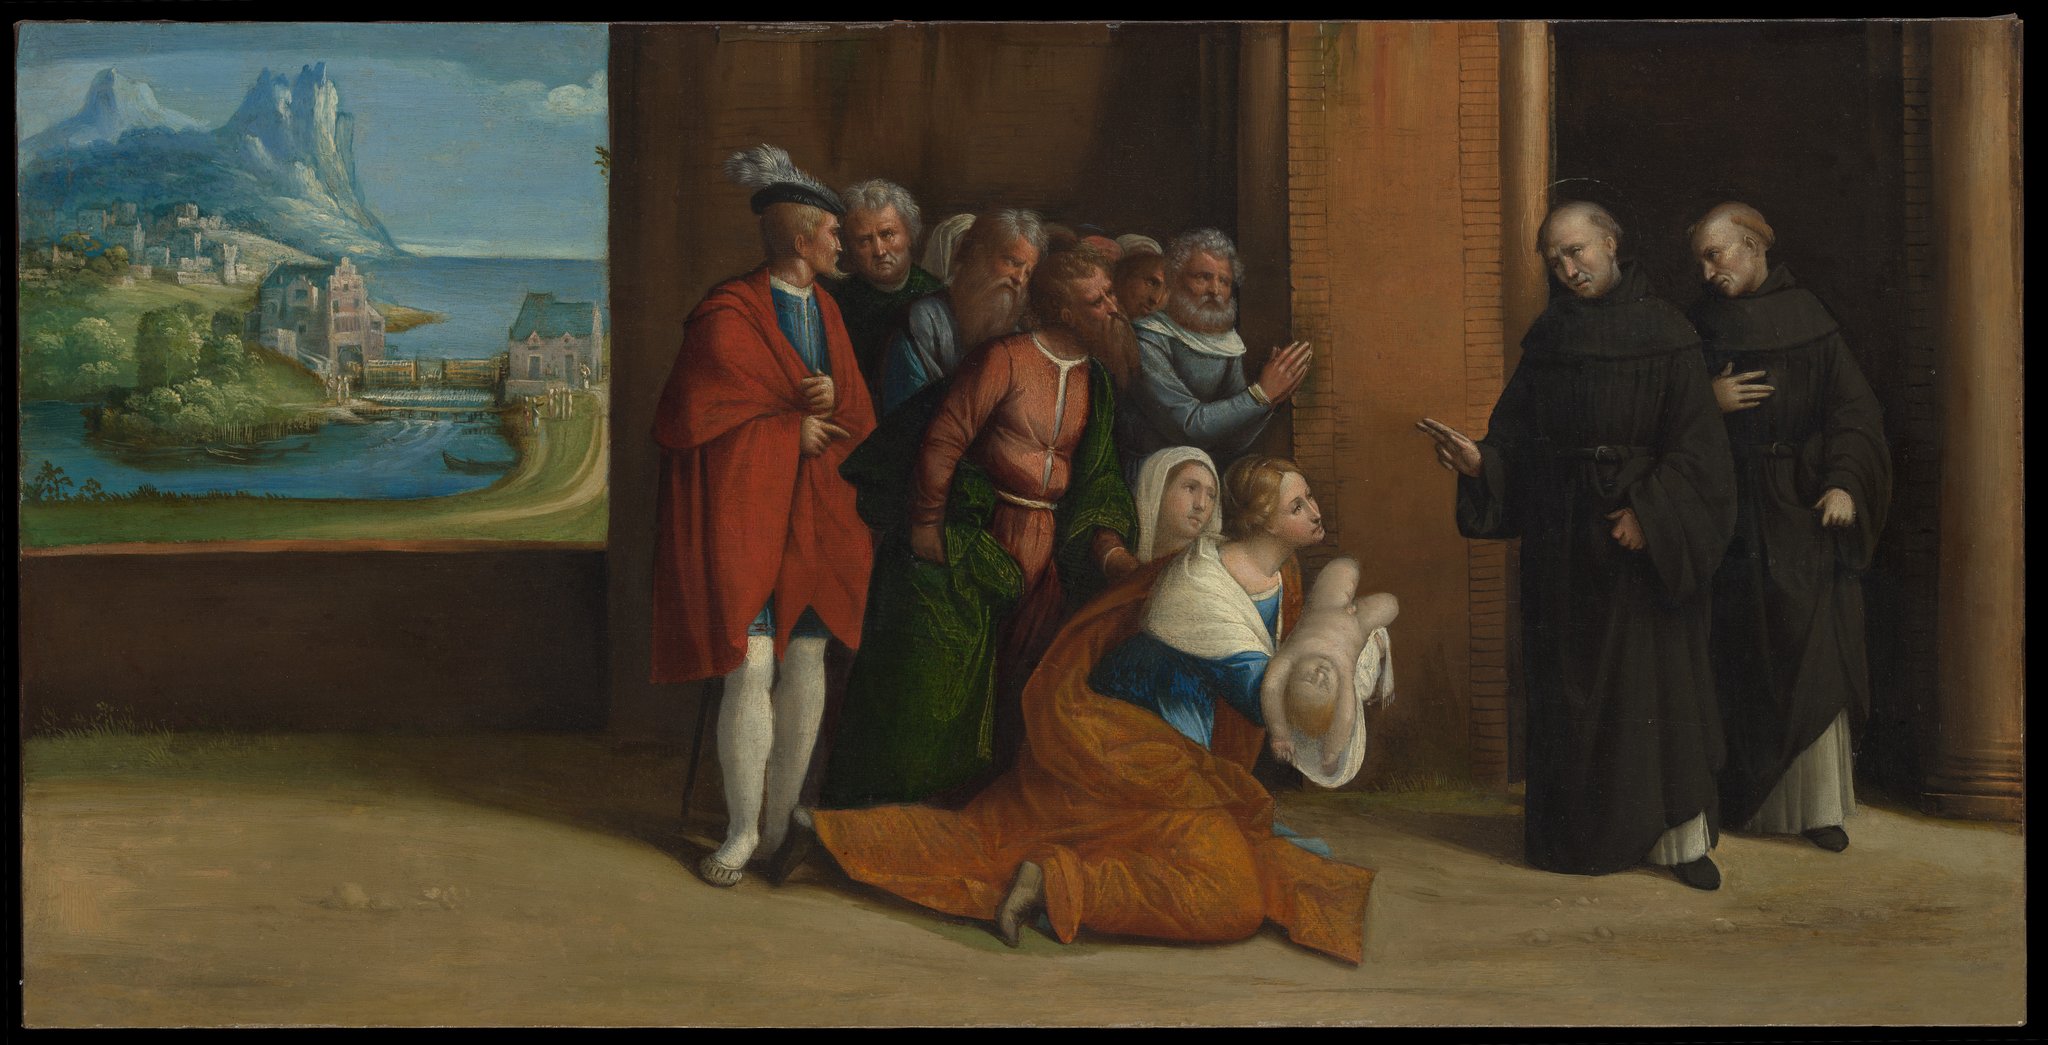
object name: painting, predella panel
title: Saint Nicholas of Tolentino Reviving a Child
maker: garofalo (benvenuto tisi da garofalo)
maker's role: artist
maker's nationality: italian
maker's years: 1481-1559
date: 1530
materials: canvas, oil, wood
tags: infants,men,women,saints